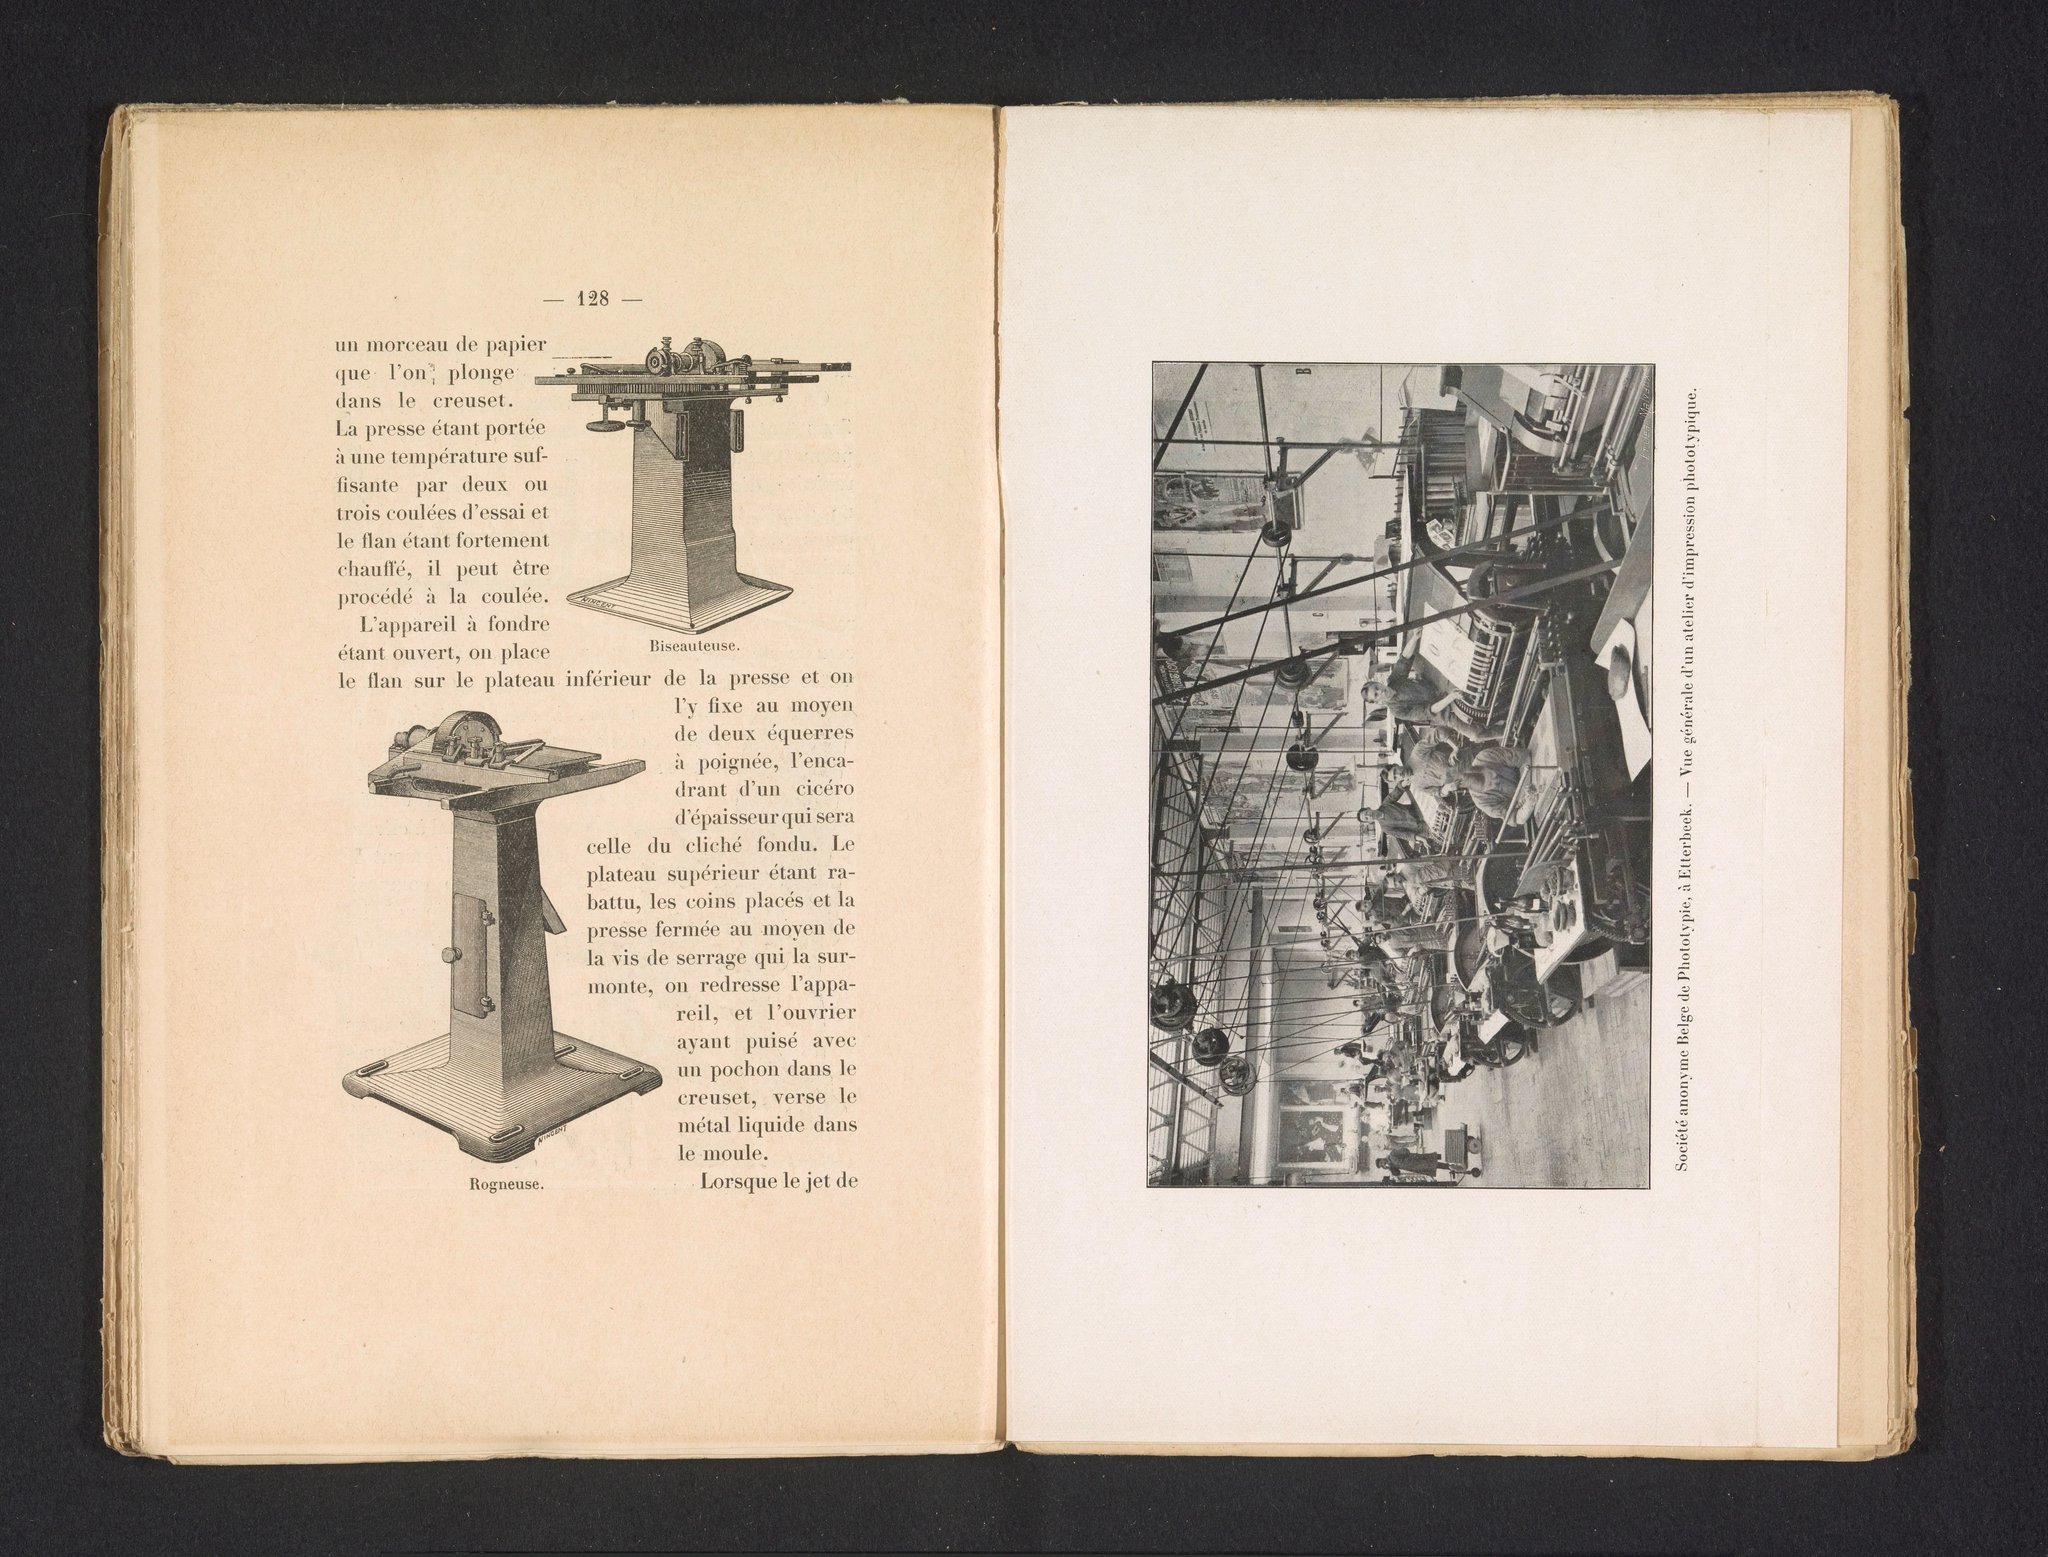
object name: photomechanical print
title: Gezicht op een drukkerij voor fotografische clichés in de Société anonyme Belge de Phototypie in Etterbeek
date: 1906-1911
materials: paper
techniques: autotype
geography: etterbeek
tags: adult man, printing press